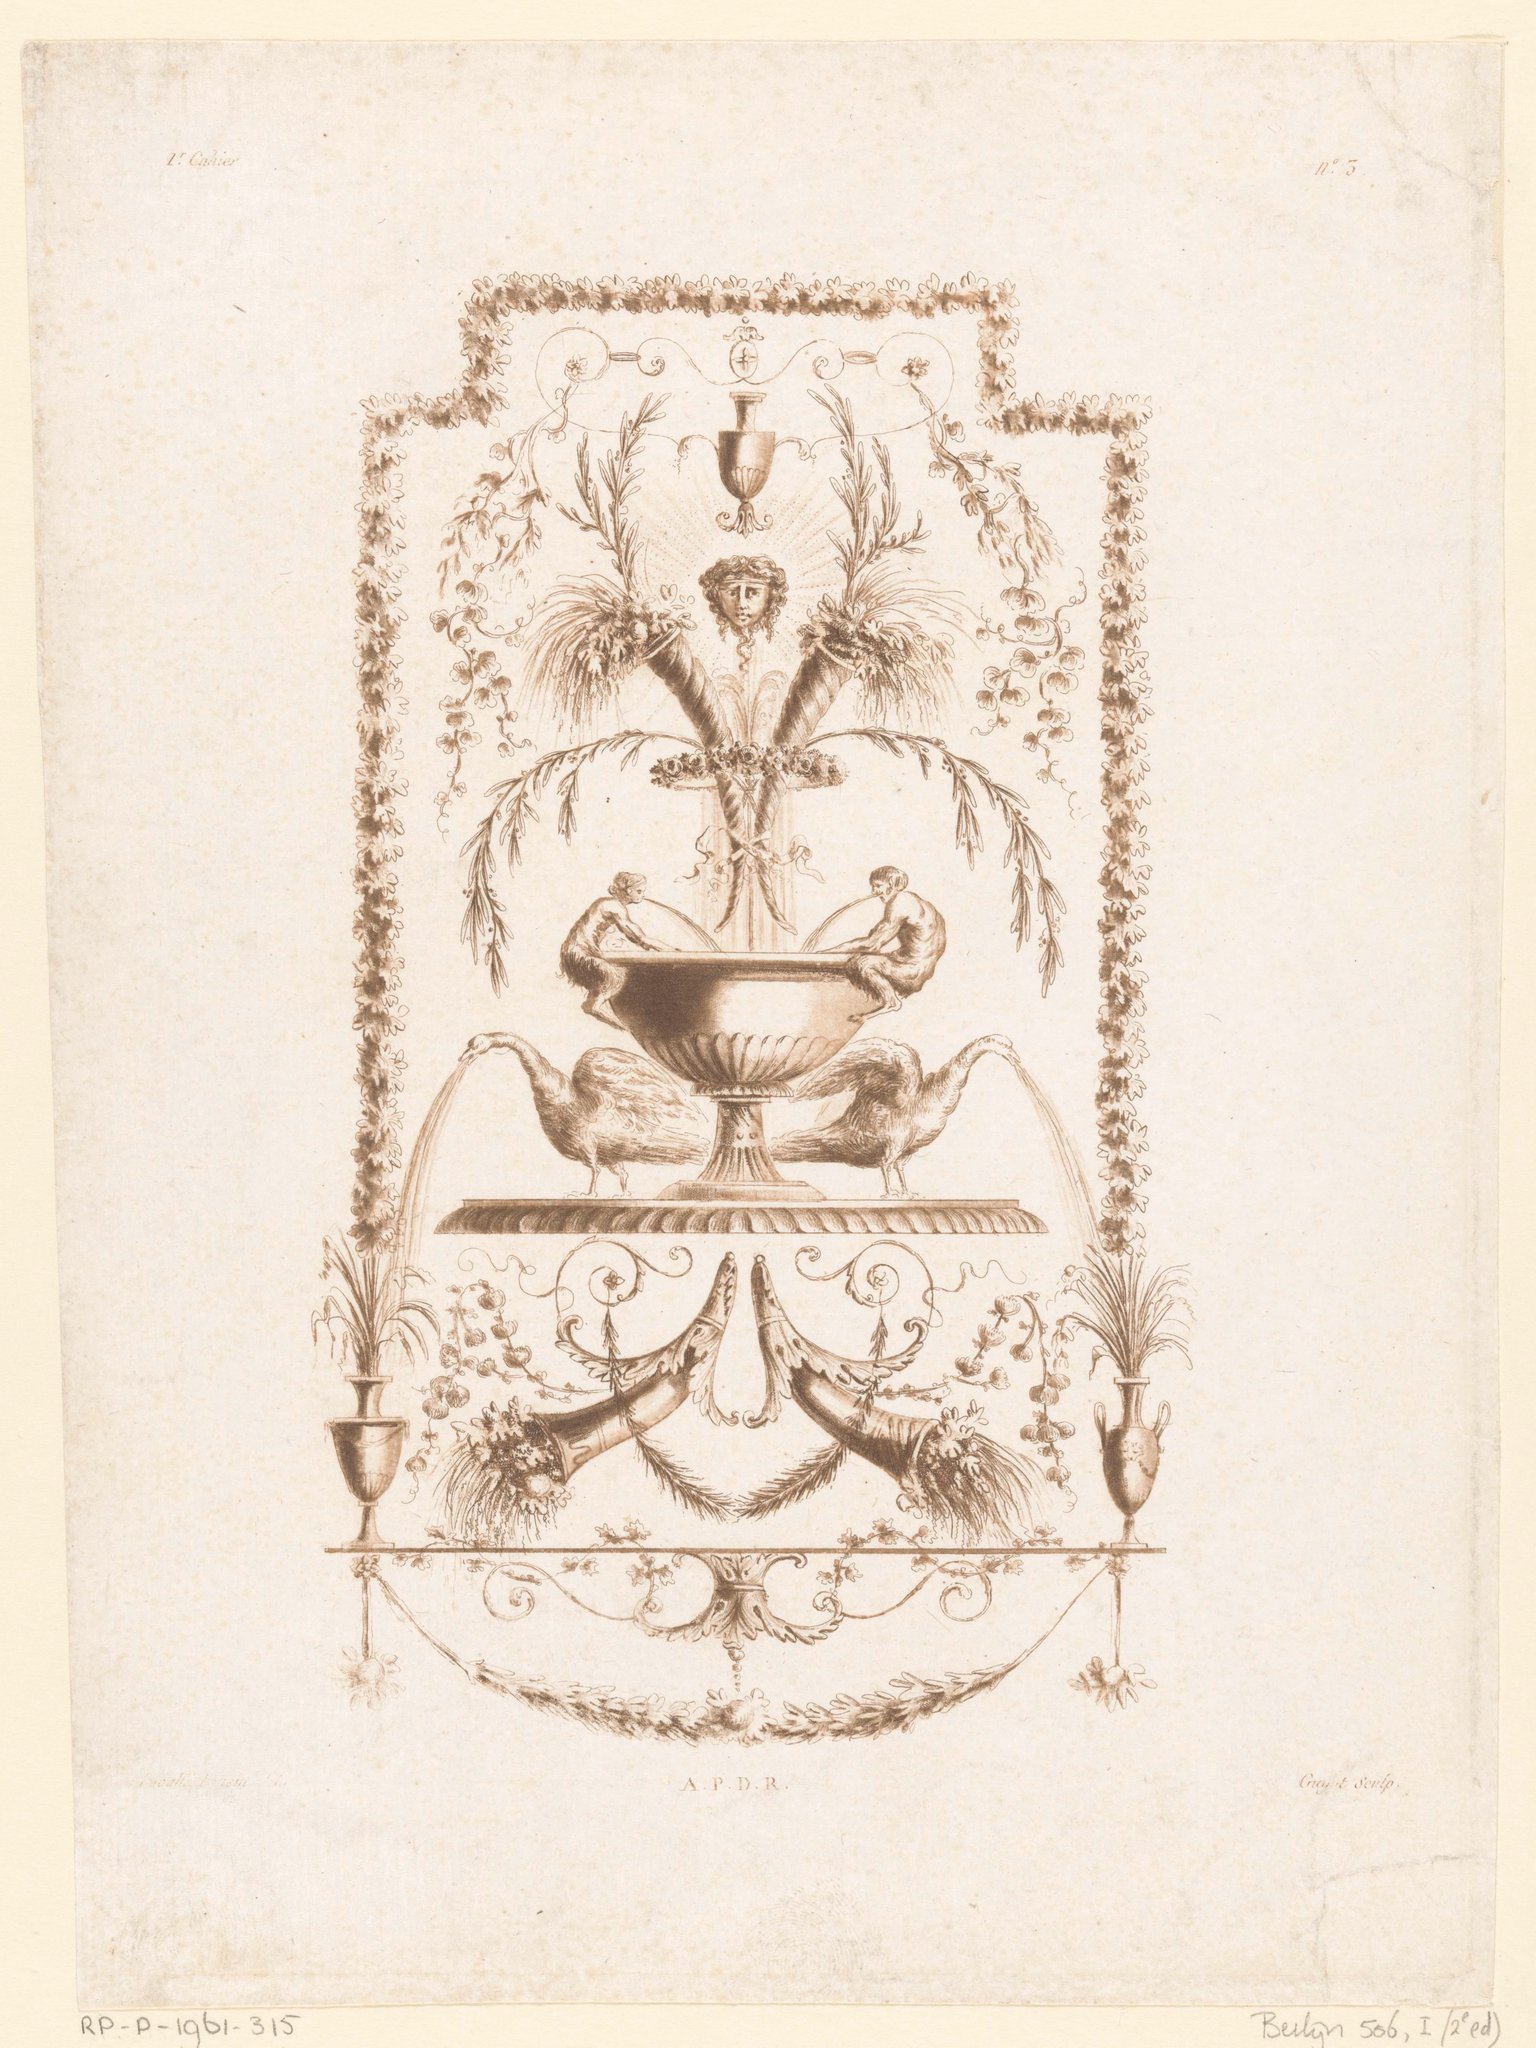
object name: print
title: Premier cahier d'Arabesques et de Decorations propres aux Artistes de ce'genre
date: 1810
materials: paper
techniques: aquatint, etching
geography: paris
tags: ornament ~ arabesque, ornamental fountain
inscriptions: collector's mark: Lugt 2228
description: Een fontein met saters en vogels met aan de boven- en onderzijde twee hoornen des overvloeds. Arabesken met vazen omringen het geheel.